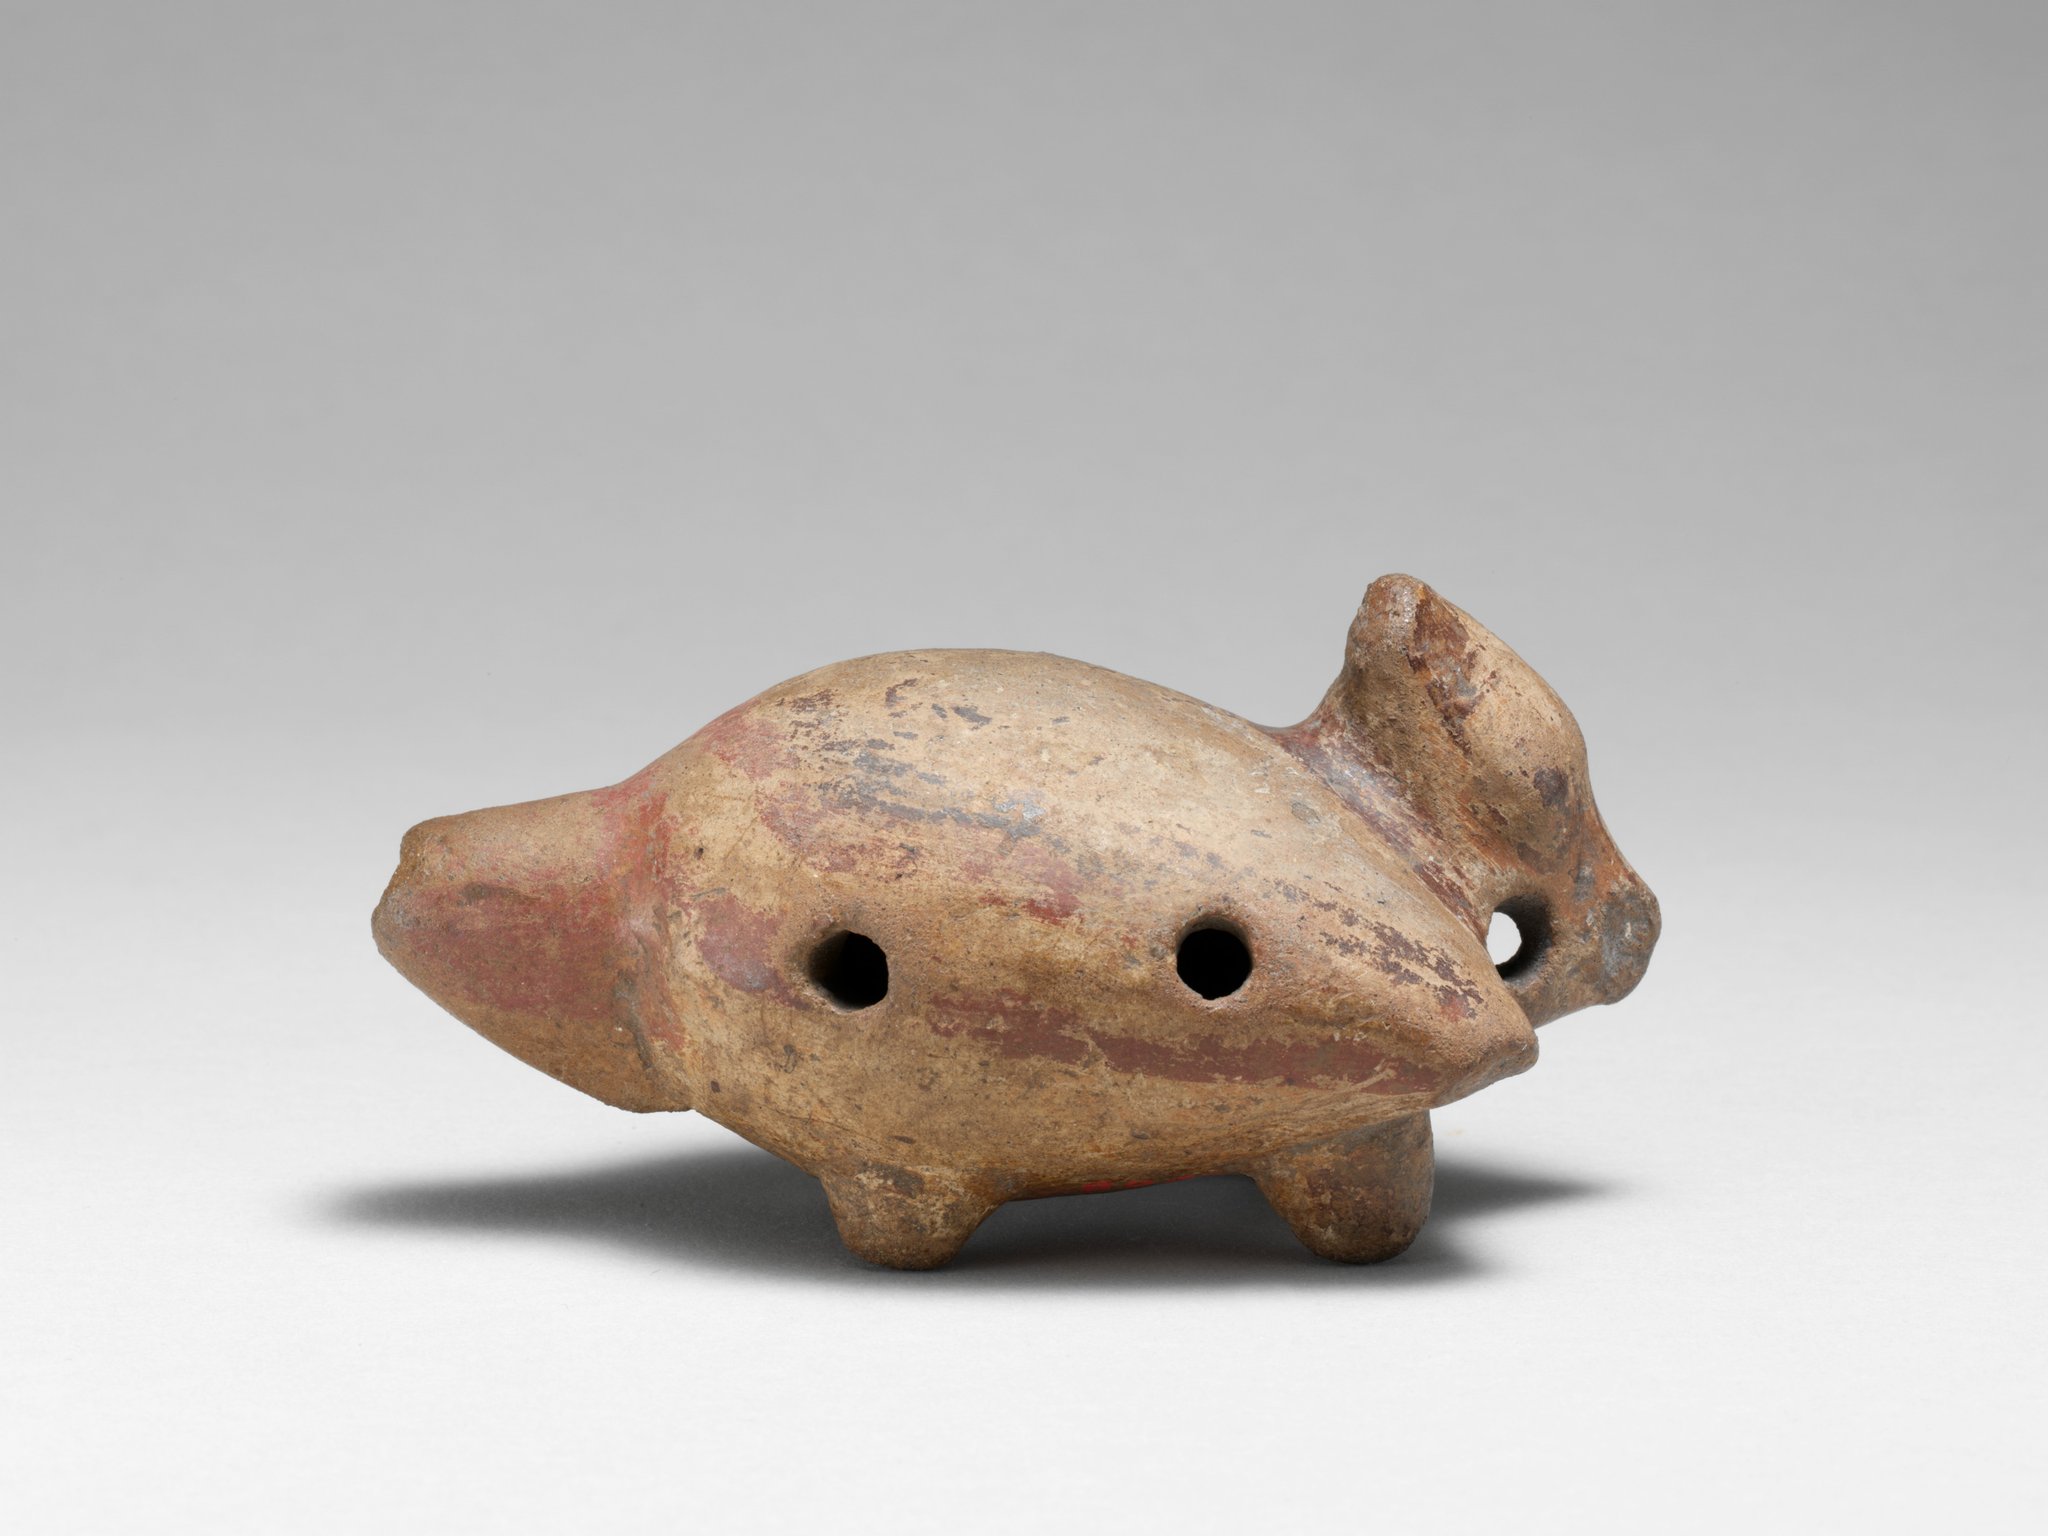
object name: pottery whistle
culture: costa rican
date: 800-1525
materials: clay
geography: costa rica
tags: animals